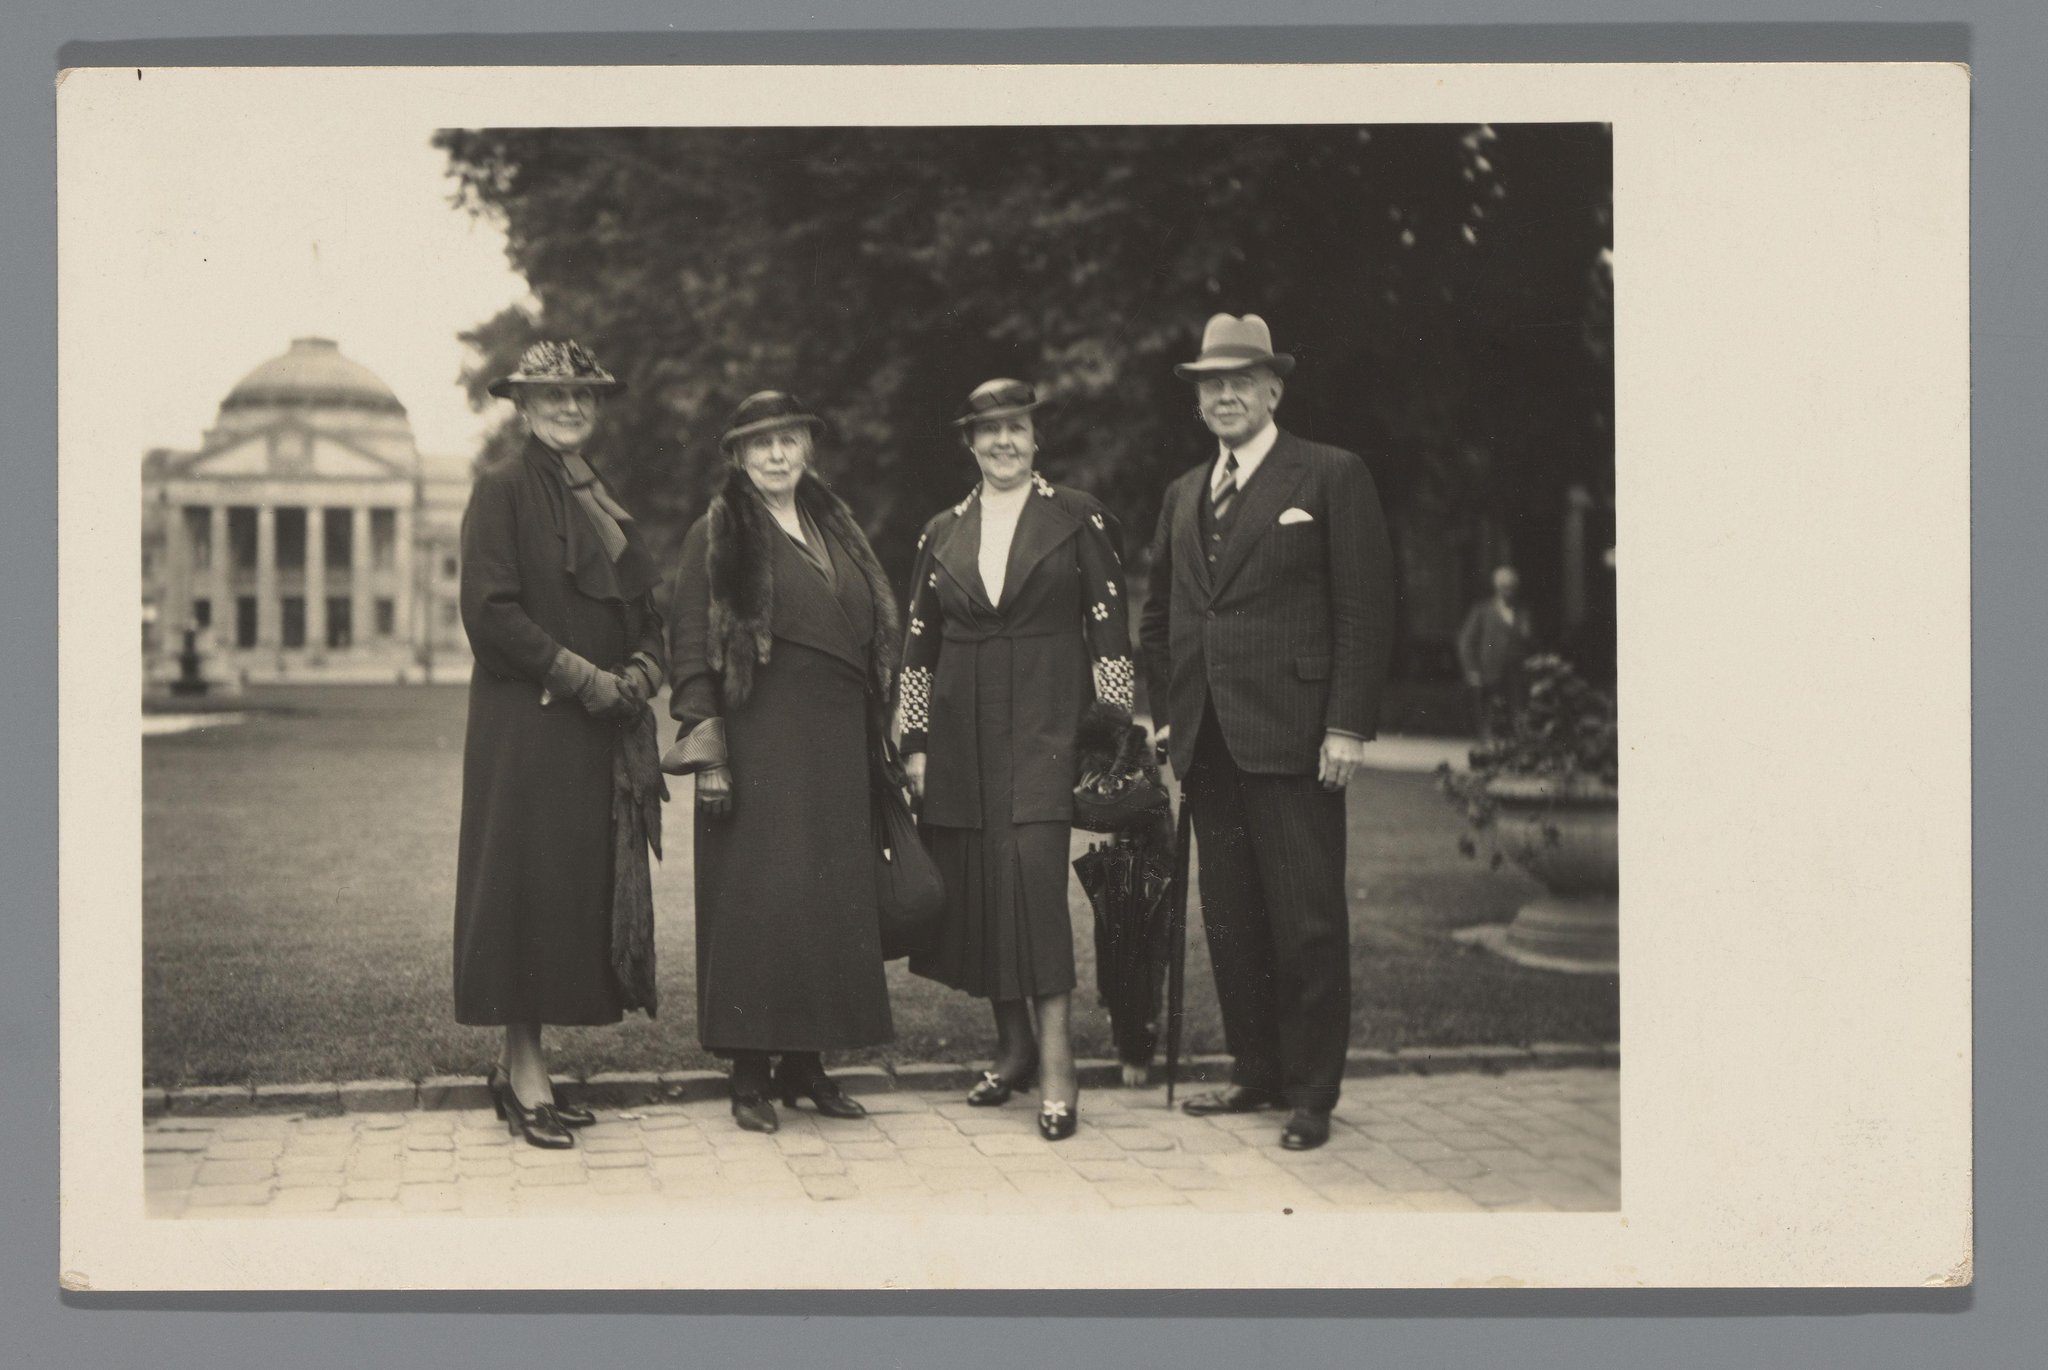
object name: photograph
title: Portret van twee vrouwen en Line en Hendrik Herman van den Berg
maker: Anonymous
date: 1937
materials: photographic support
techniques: photography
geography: wiesbaden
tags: batavia, amsterdam, hendrik herman van den berg, caroline louise van den berg-van den berg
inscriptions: name: ‘H. Reich Foto Wiesbaden, Herdertr. 25’, inscription: ‘Wiesbaden / 1937’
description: Portret van twee vrouwen en Line en Hendrik Herman van den Berg in Wiesbaden.